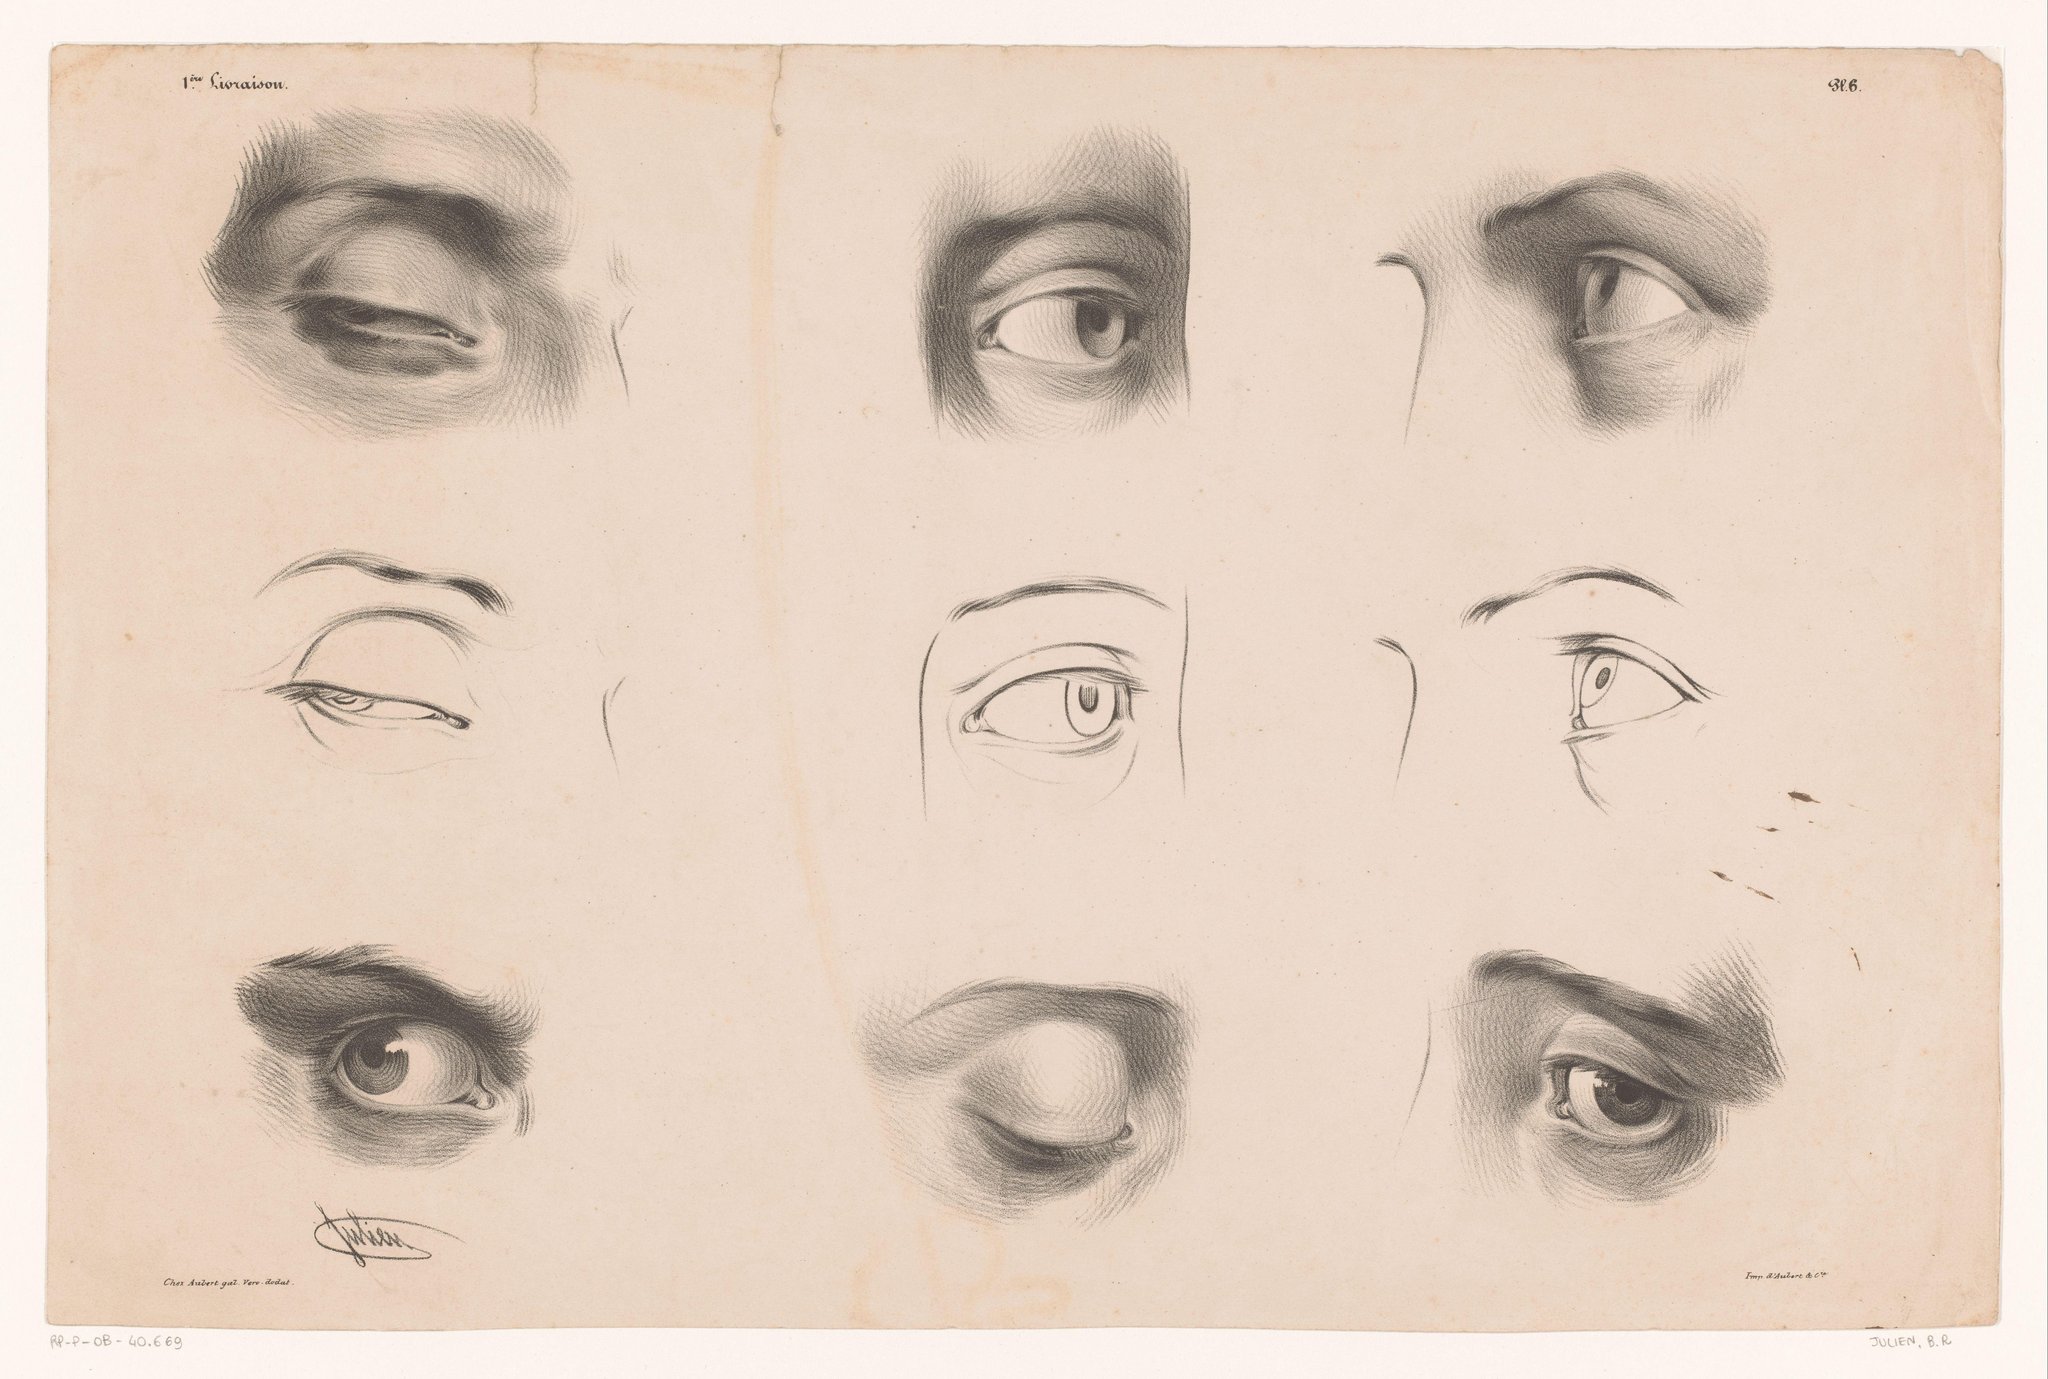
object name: print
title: Cours de dessin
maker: bernard romain julien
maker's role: print maker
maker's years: 1802-1871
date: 1836-1843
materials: paper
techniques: lithograph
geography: paris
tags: eyes